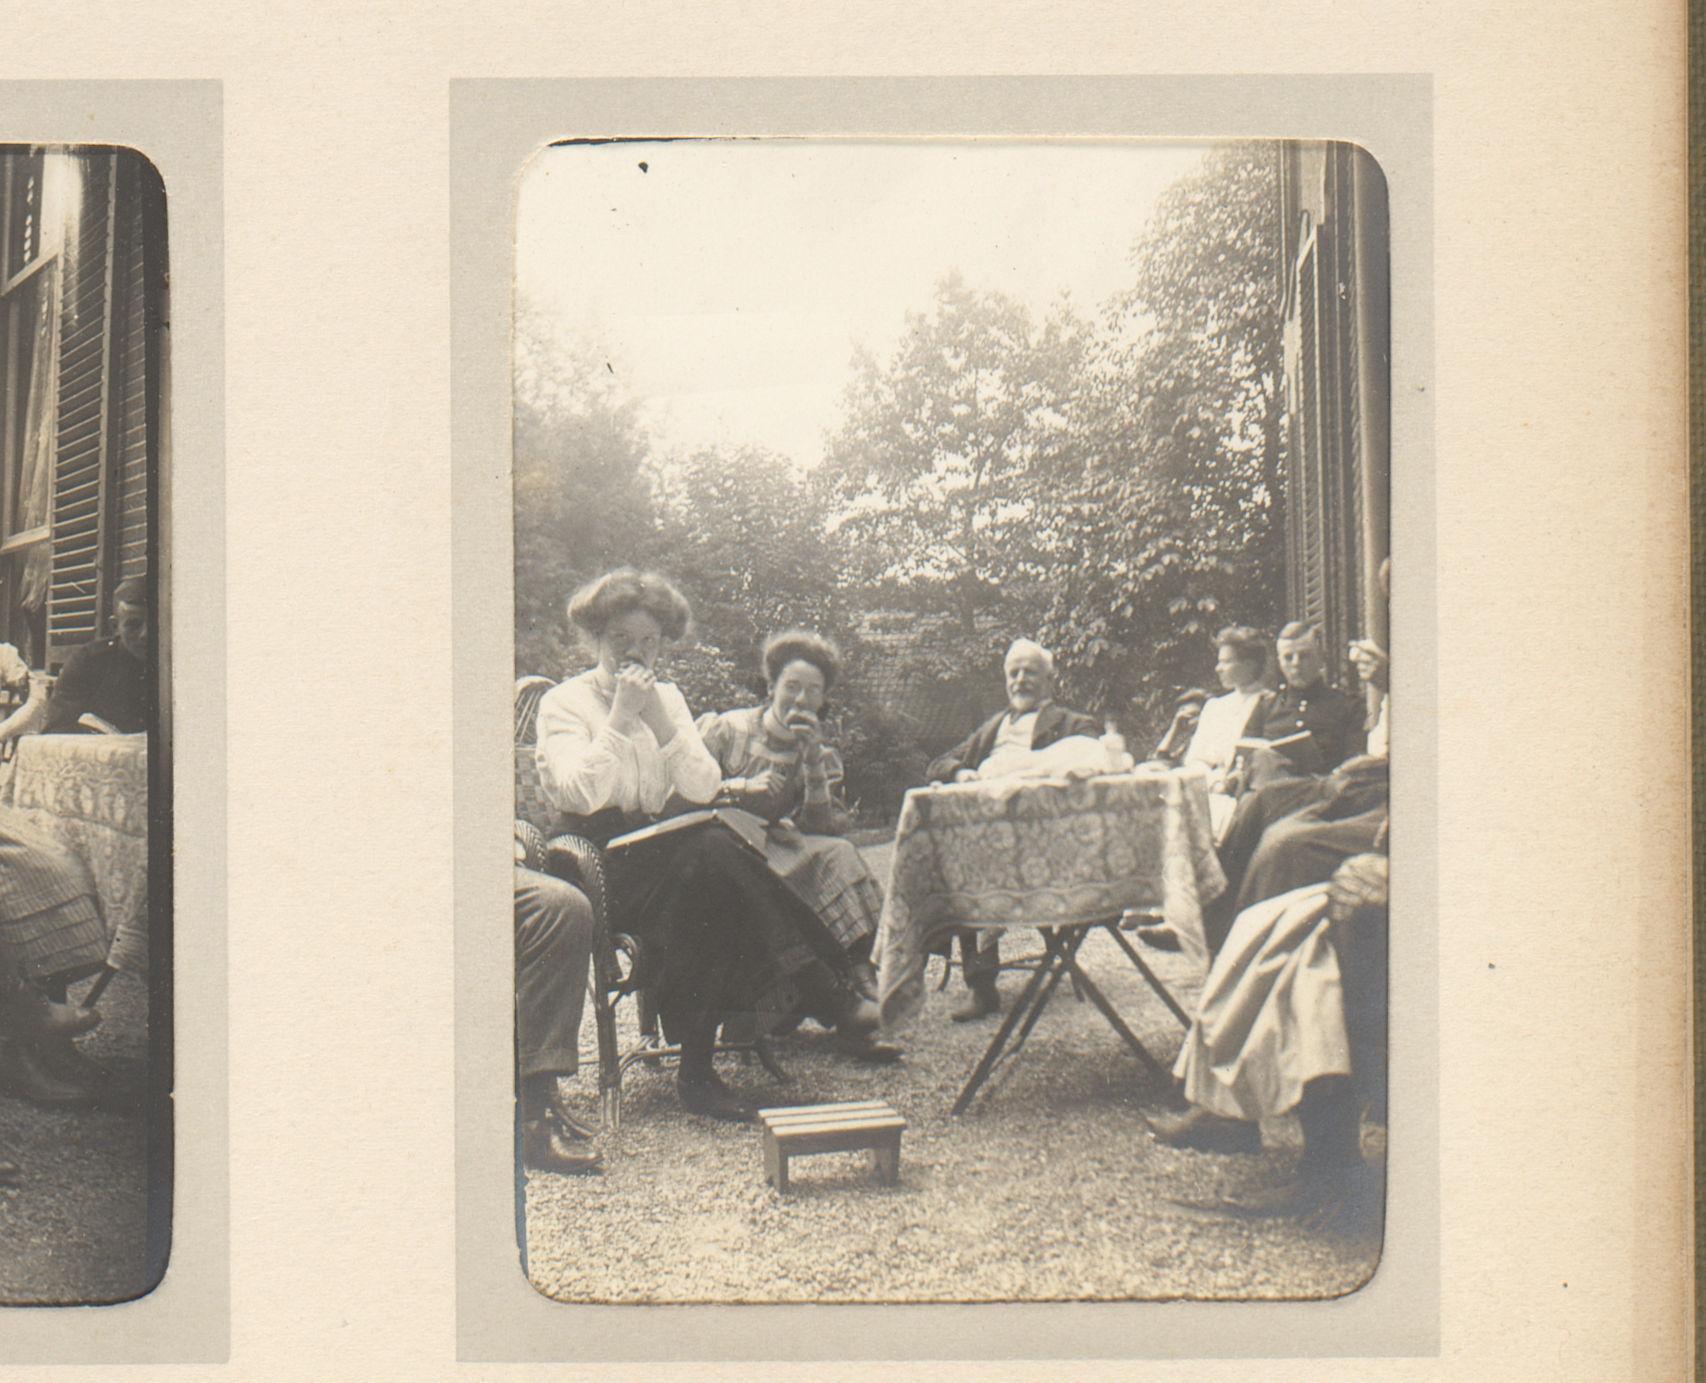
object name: photograph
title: Gezelschap zit buiten rondom een tafel, twee vrouwen bijten in een vrucht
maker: liesbeth overhoff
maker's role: fotograaf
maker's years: 1895-1969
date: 1911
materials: paper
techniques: gelatin silver print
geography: ellecom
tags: midday meal, lunch - cc - out of doors, biting, forest, wood, anonymous historical persons portrayed in a group, in a group-portrait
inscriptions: inscription: ‘Ellekom’